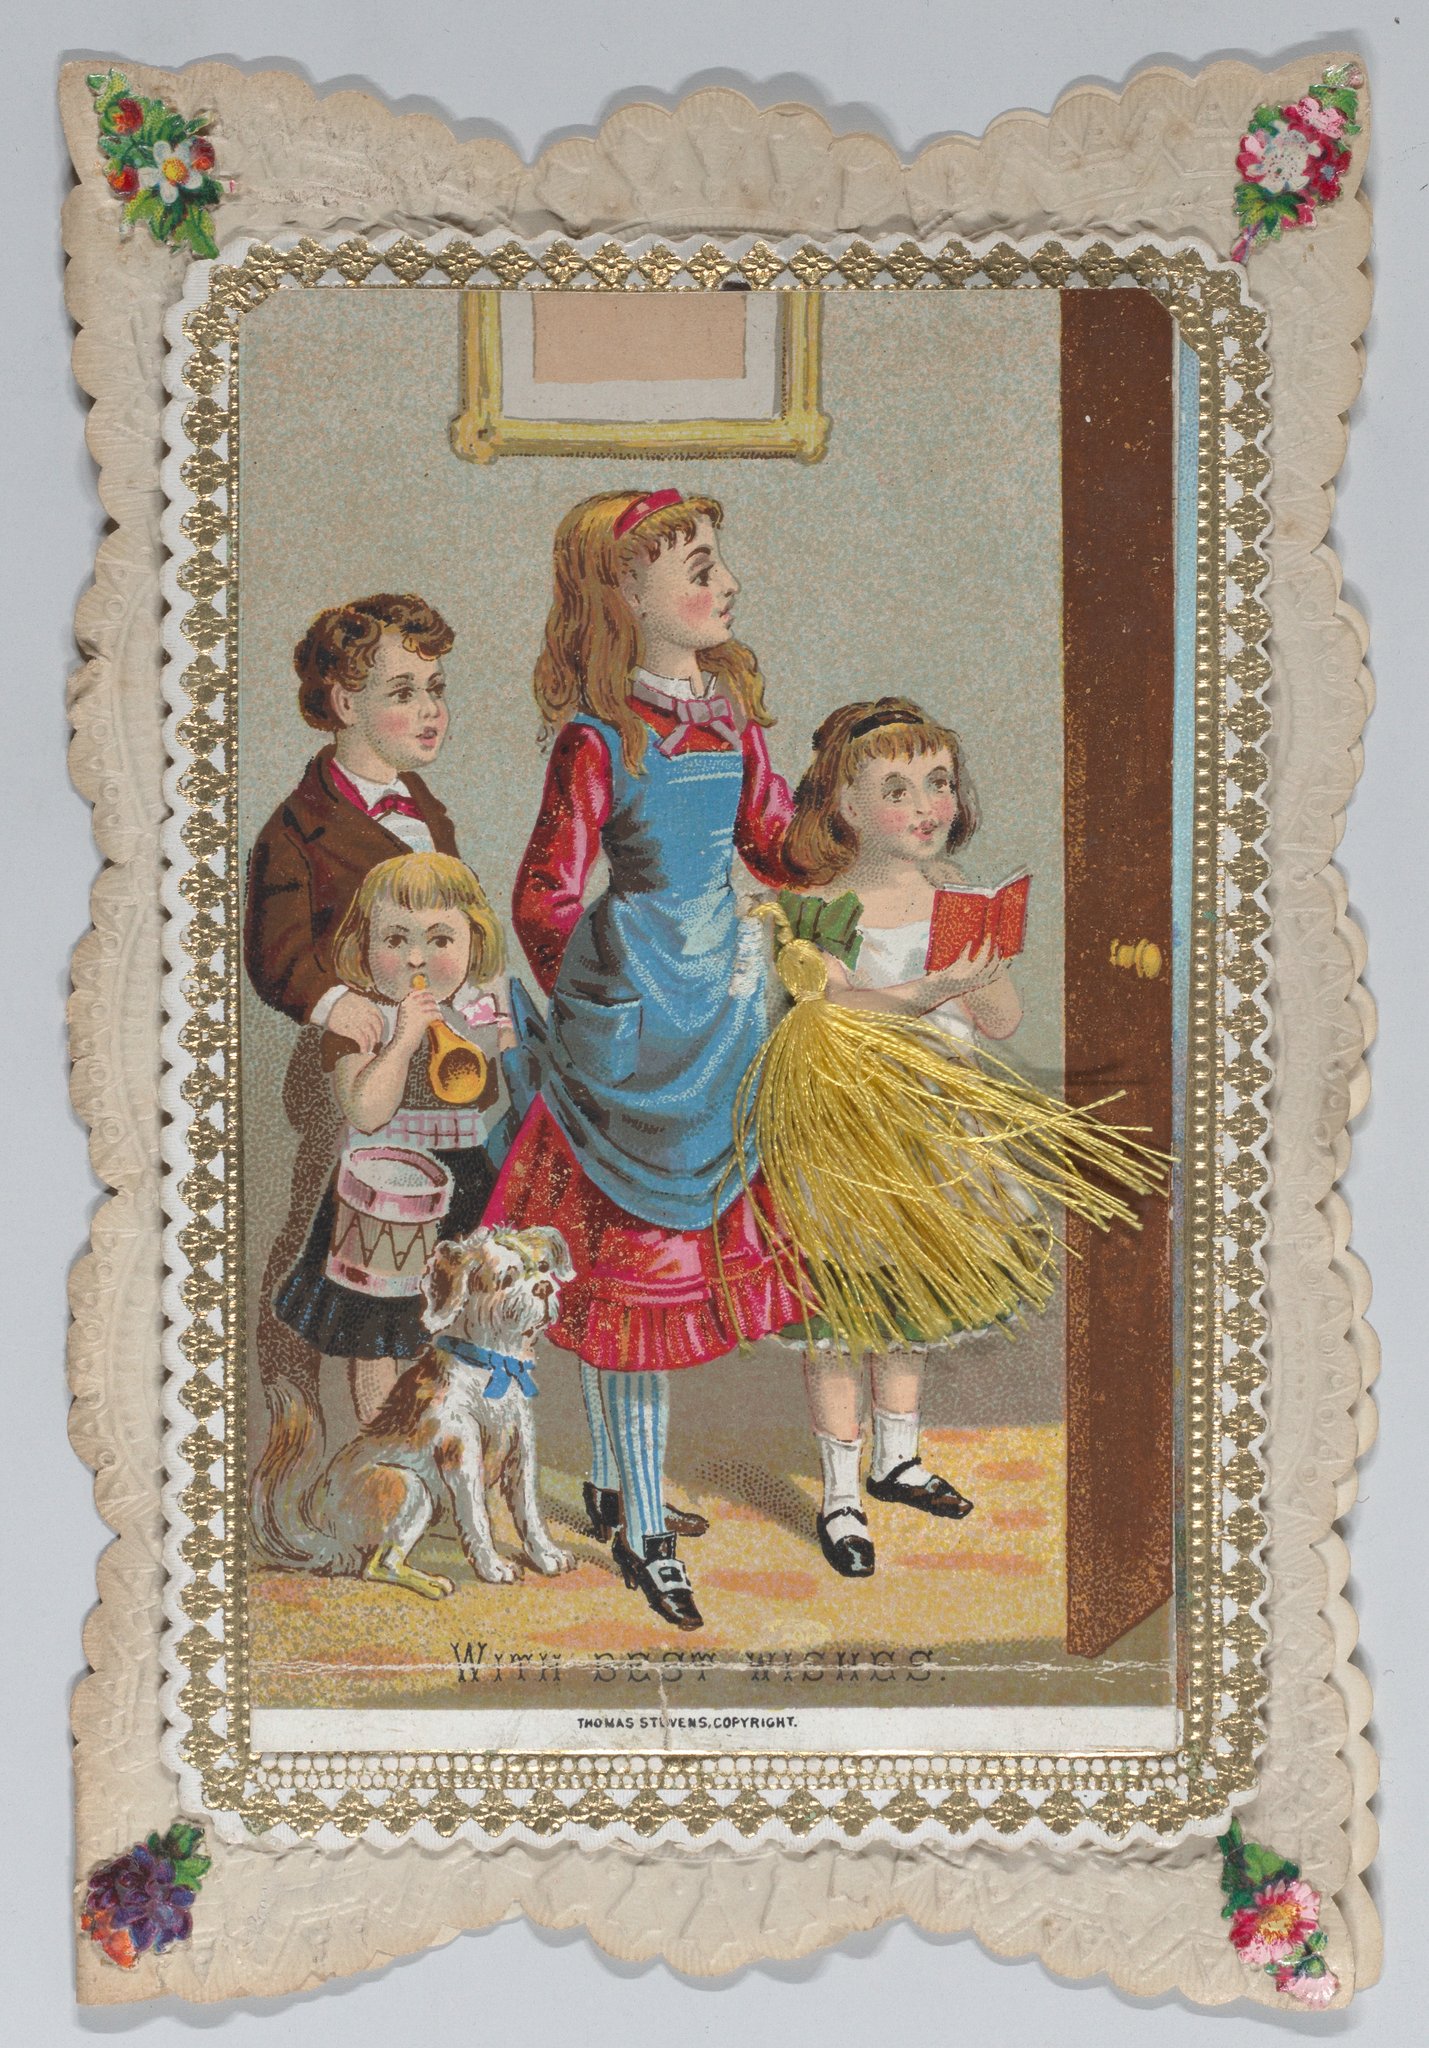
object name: valentine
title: Valentine - Mechanical - pull down tassel reveals scene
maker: anonymous, british, 19th century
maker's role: artist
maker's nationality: british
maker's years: 1800-1900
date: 1875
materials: ink, paper, ribbon, silk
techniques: chromolithography, cutting, embossing, gilding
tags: boys,girls,dogs